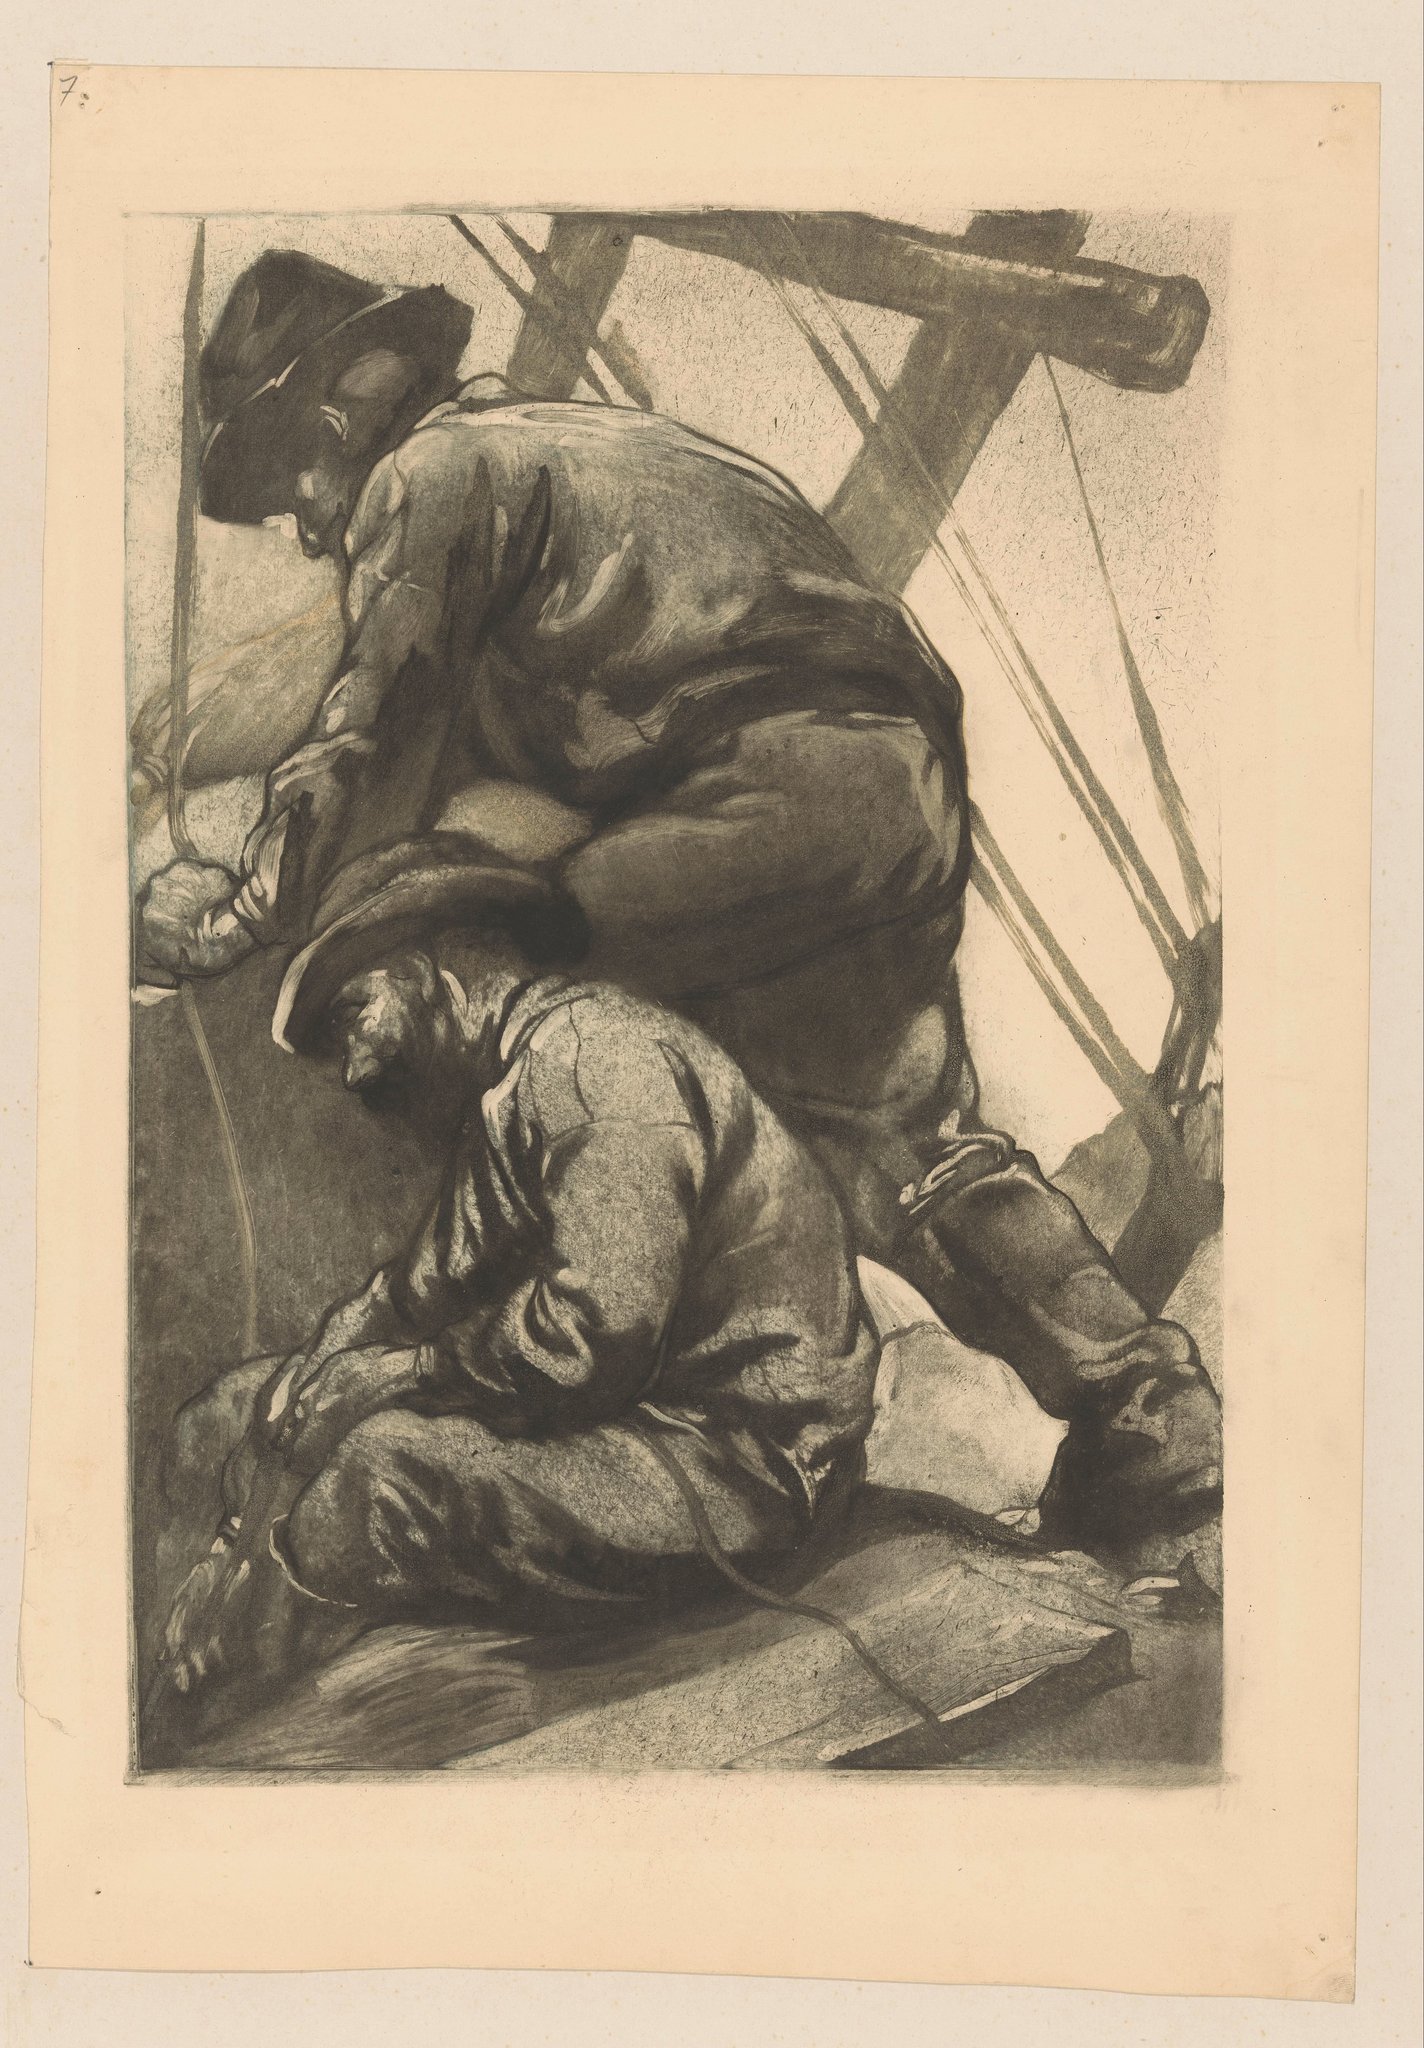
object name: print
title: Twee arbeiders met touwen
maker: johannes josephus aarts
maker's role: draughtsman, print maker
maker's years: 1871-1934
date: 1881-1934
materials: paper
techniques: lithograph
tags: working class, labourers, tools, aids, implements ~ crafts and industries: rope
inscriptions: collector's mark: Lugt 2760, collector's mark: Lugt 2228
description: Twee mannen in werkkleding en met hoed. Zowel de zittende man op de voorgrond als de staande man achter hem houden een touw vast.